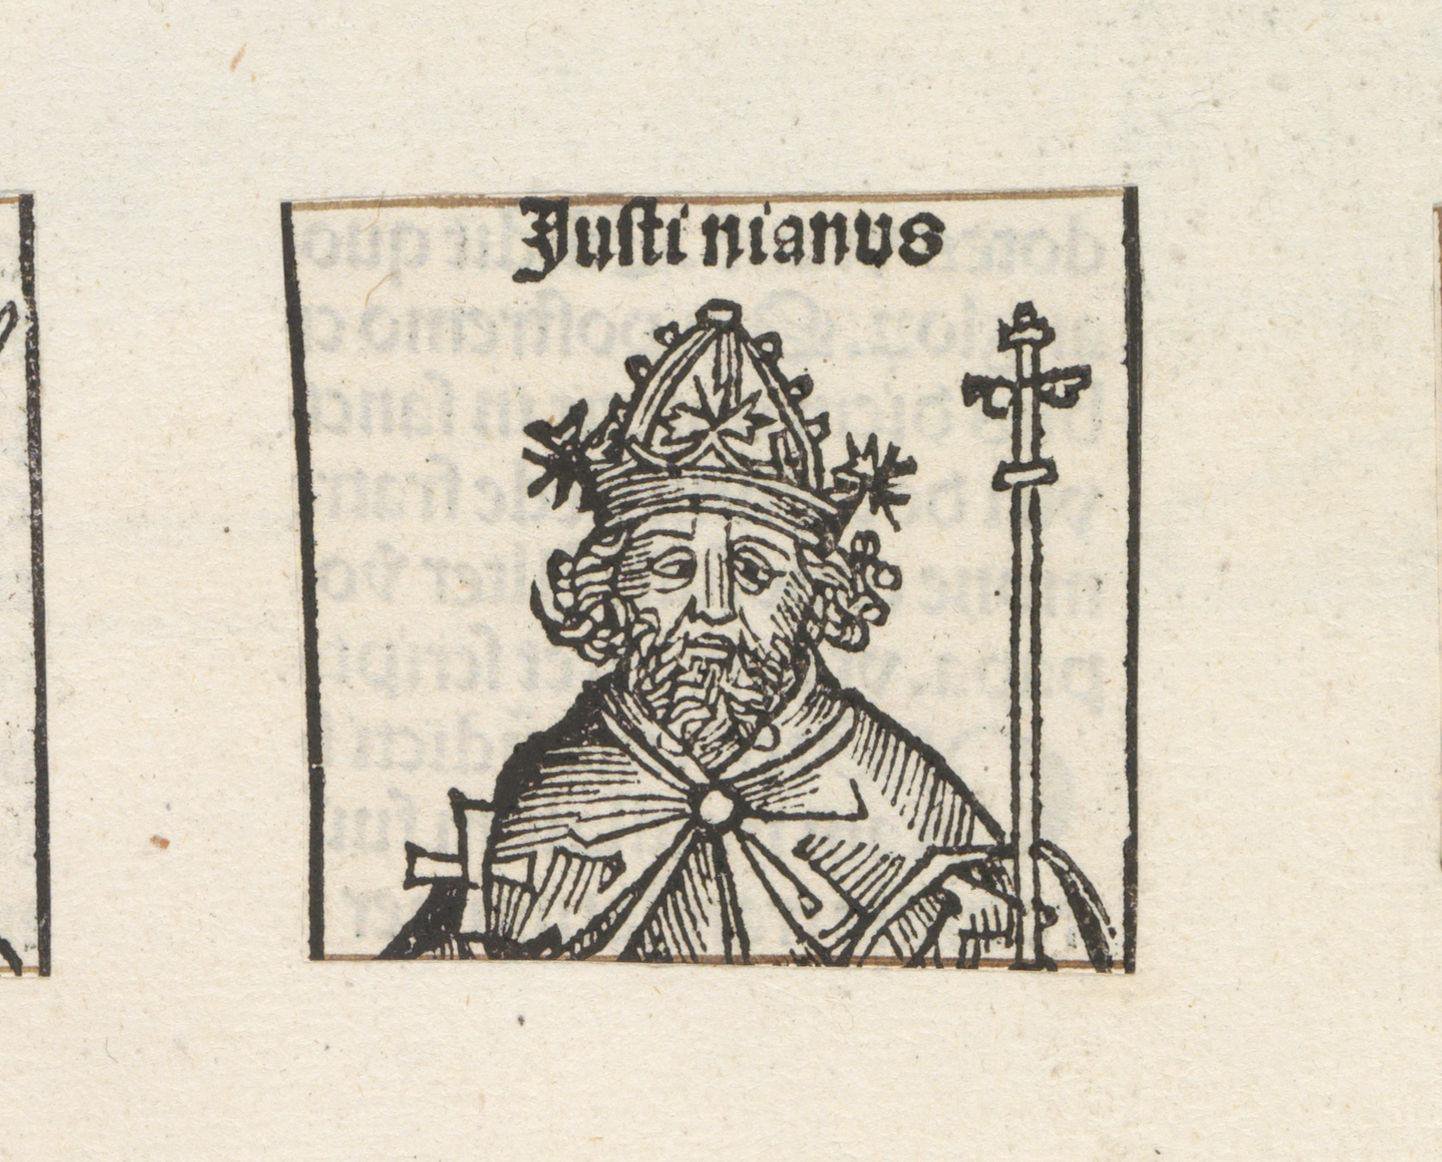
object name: book illustration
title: Keizer Justinianus II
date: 1493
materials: paper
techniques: letterpress printing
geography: nuremberg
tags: emperor, king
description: Een halve koning, naar voren gericht. In zijn handen heeft hij een rijksappel en een scepter. De voorstelling is onderdeel van de opeenvolging keizers in de Liber Chronicarum. De tekst identificeert de man als Justinianus II. De prent maakt deel uit van een album.